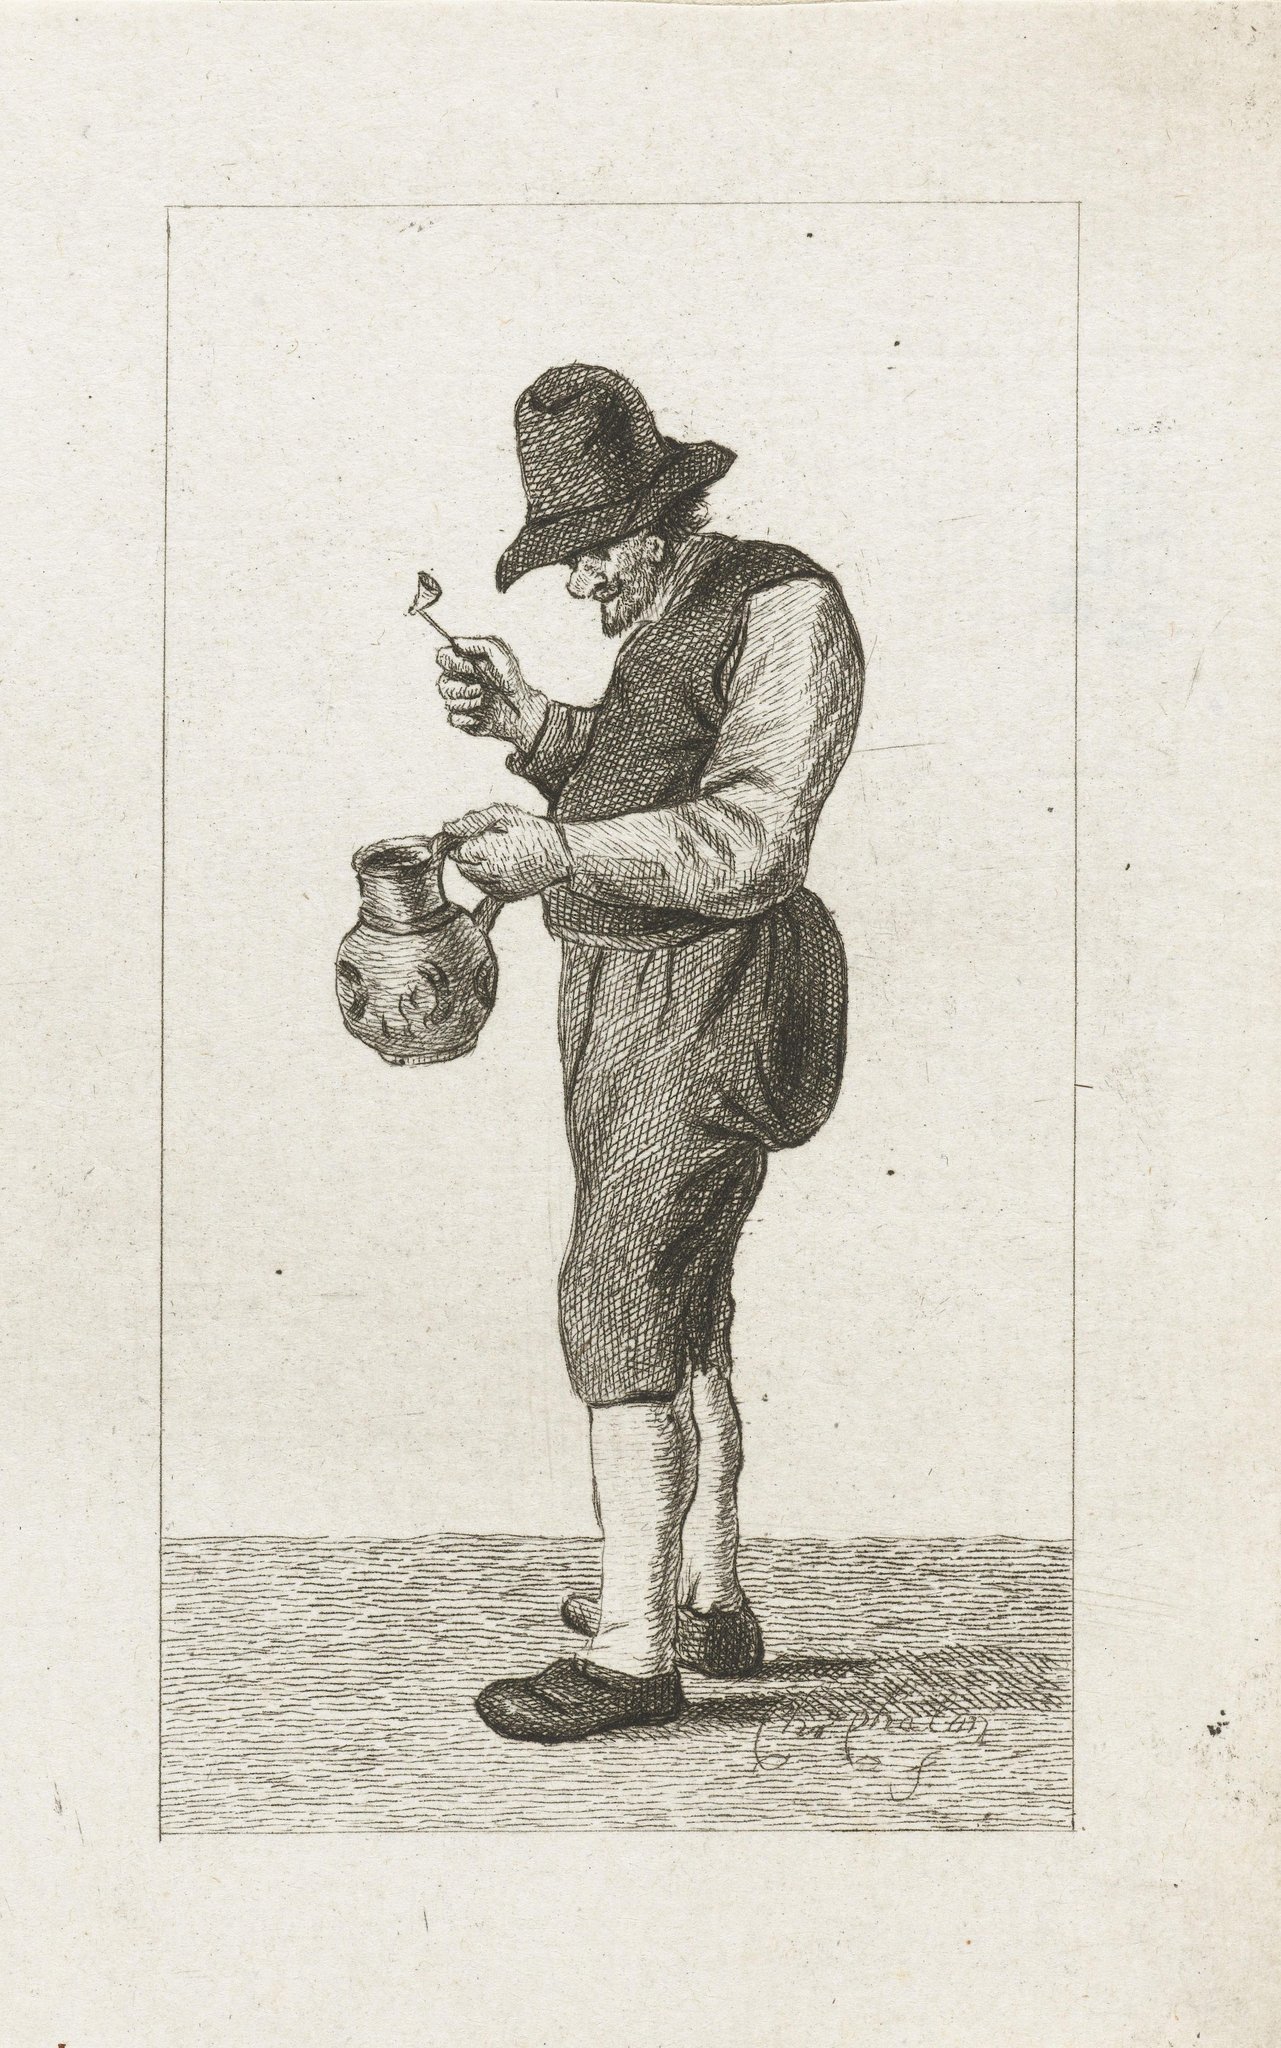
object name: print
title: Staande man met pijp en kruik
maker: pieter de mare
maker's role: print maker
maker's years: 1758-1796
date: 1779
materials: paper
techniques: etching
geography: leiden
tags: pipe ~ tobacco, jar, jug (used as drinking-vessel), the (nude) human figure; 'corpo humano' (ripa) (+ old male (human being))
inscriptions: collector's mark: Lugt 2233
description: Een oude man, naar links. Hij houdt in zijn rechterhand een pijp omhoog. In zijn linkerhand heeft hij een kruik.